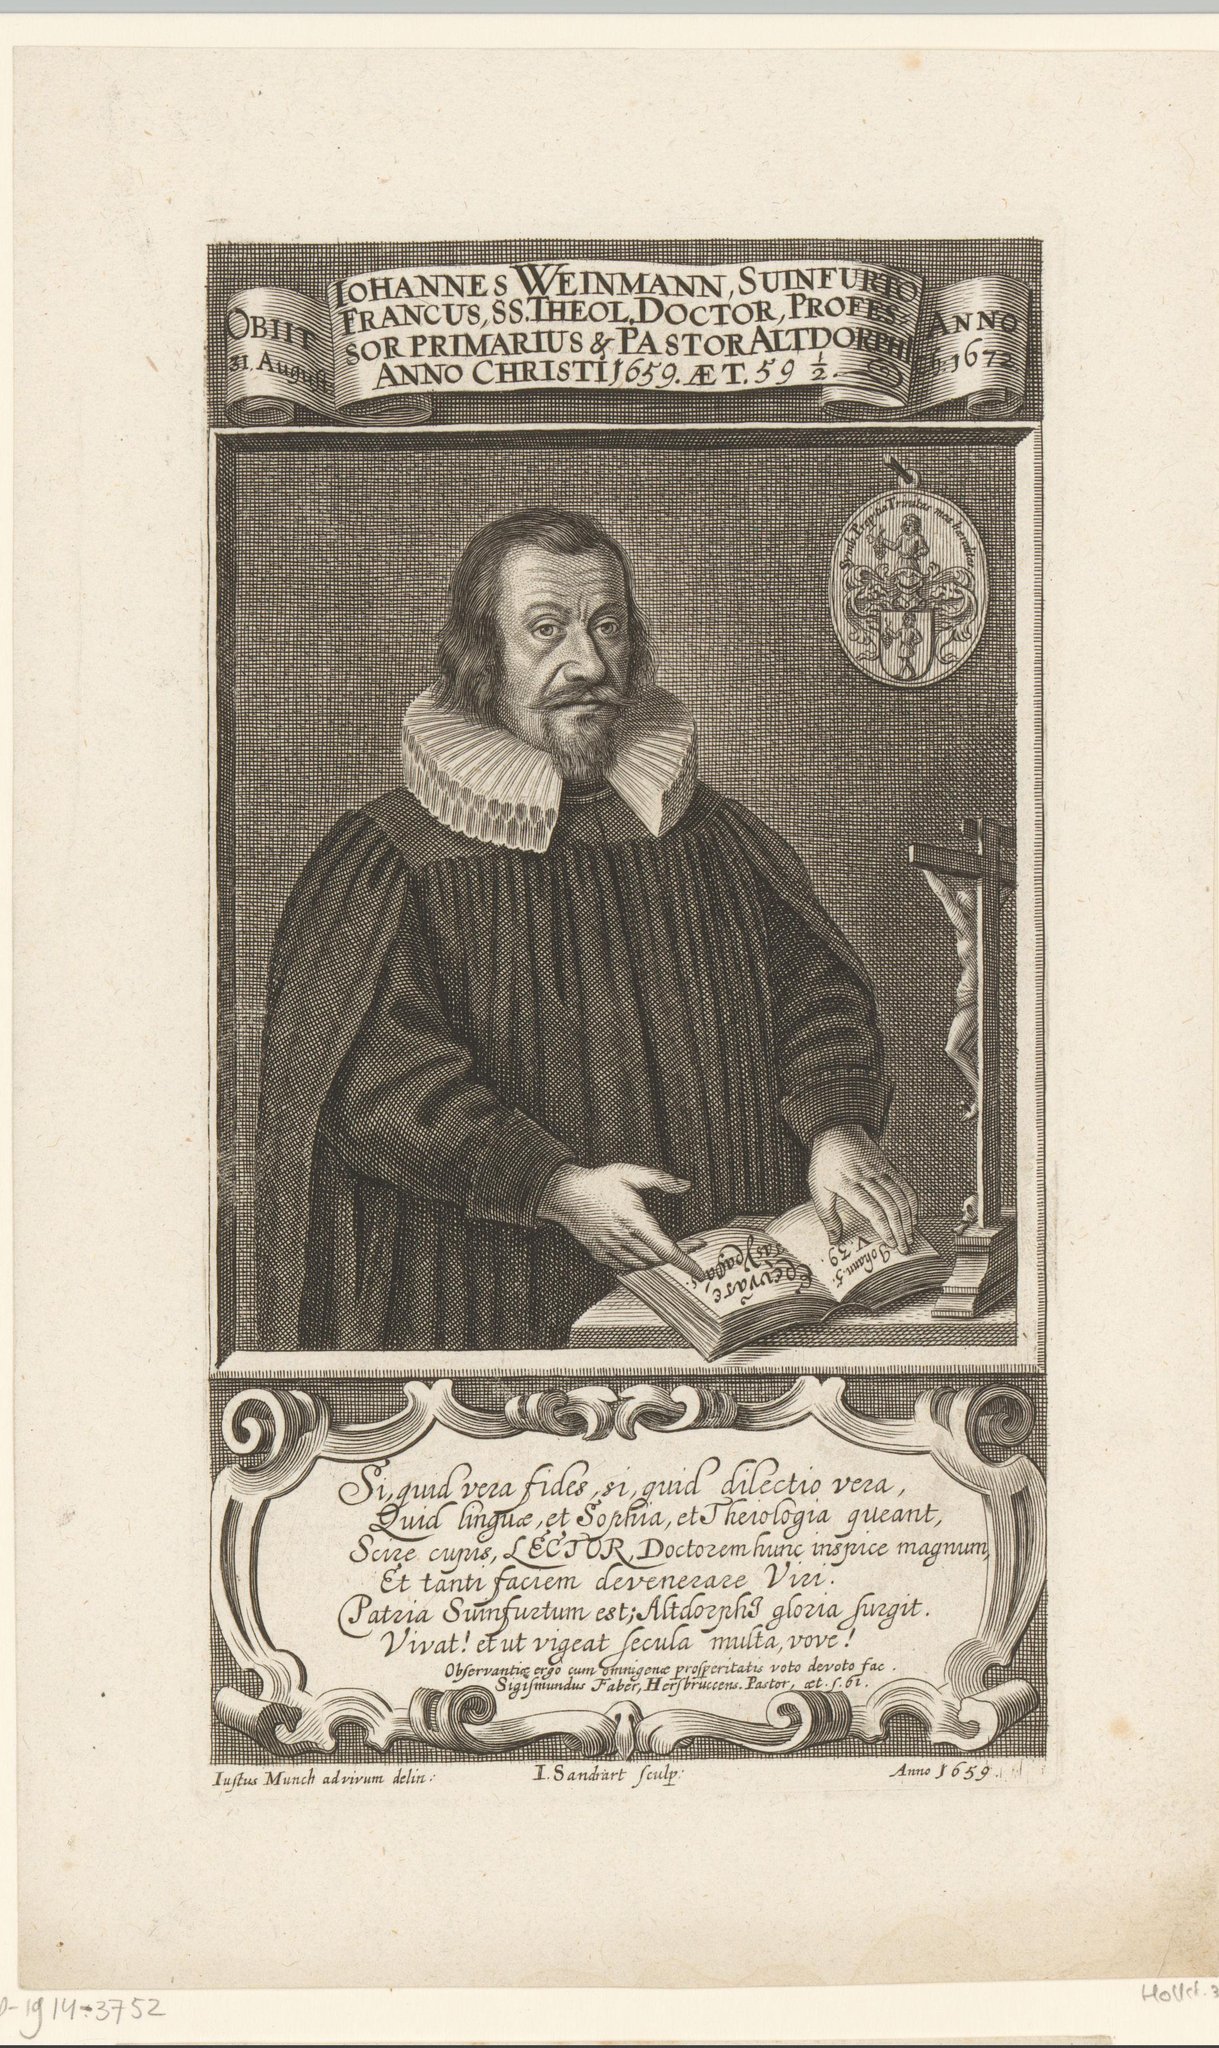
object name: print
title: Portret van Johann Weinmann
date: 1673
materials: paper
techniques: engraving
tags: theologian, historical persons, book, crucifix ~ personal devotion, armorial bearing, heraldry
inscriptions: collector's mark: Lugt 2228